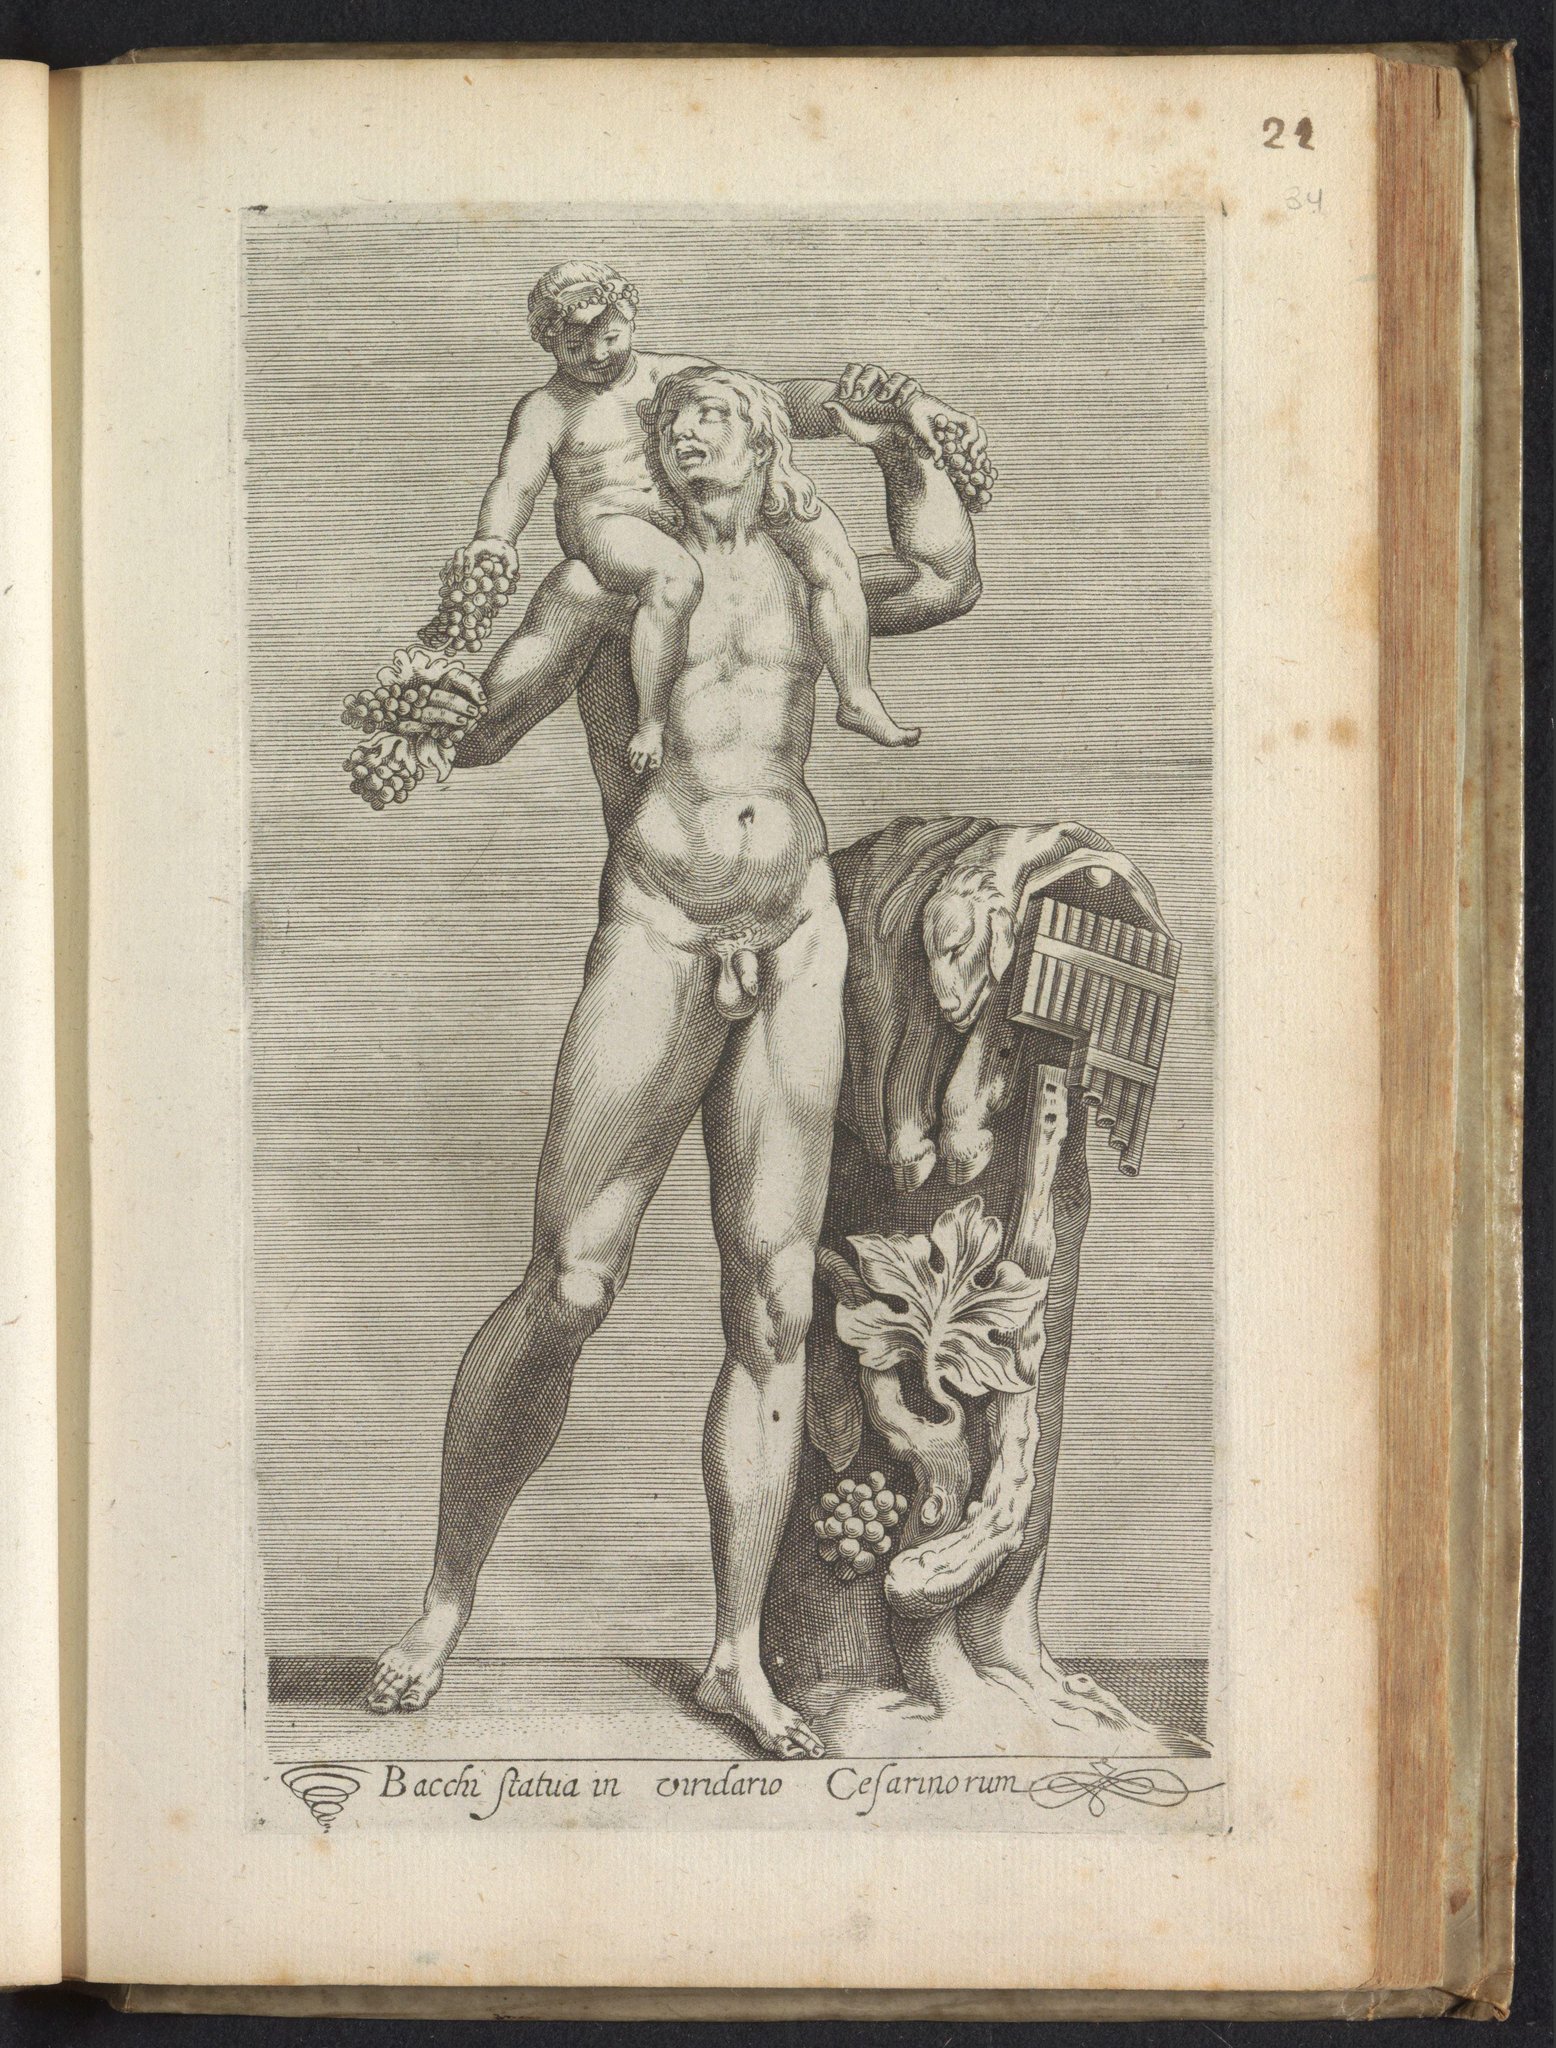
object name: print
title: Sculptuur van Silenus met de jonge Bacchus op zijn schouders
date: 1584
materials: paper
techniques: engraving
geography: italy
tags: bacchus brought up by satyrs, maenads and silenus, piece of sculpture, reproduction of a piece of sculpture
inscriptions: number: ‘21’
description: Deze prent maakt deel uit van een set van 79 prenten (+ titelprent) met voorstellingen van antieke sculpturen in Rome.